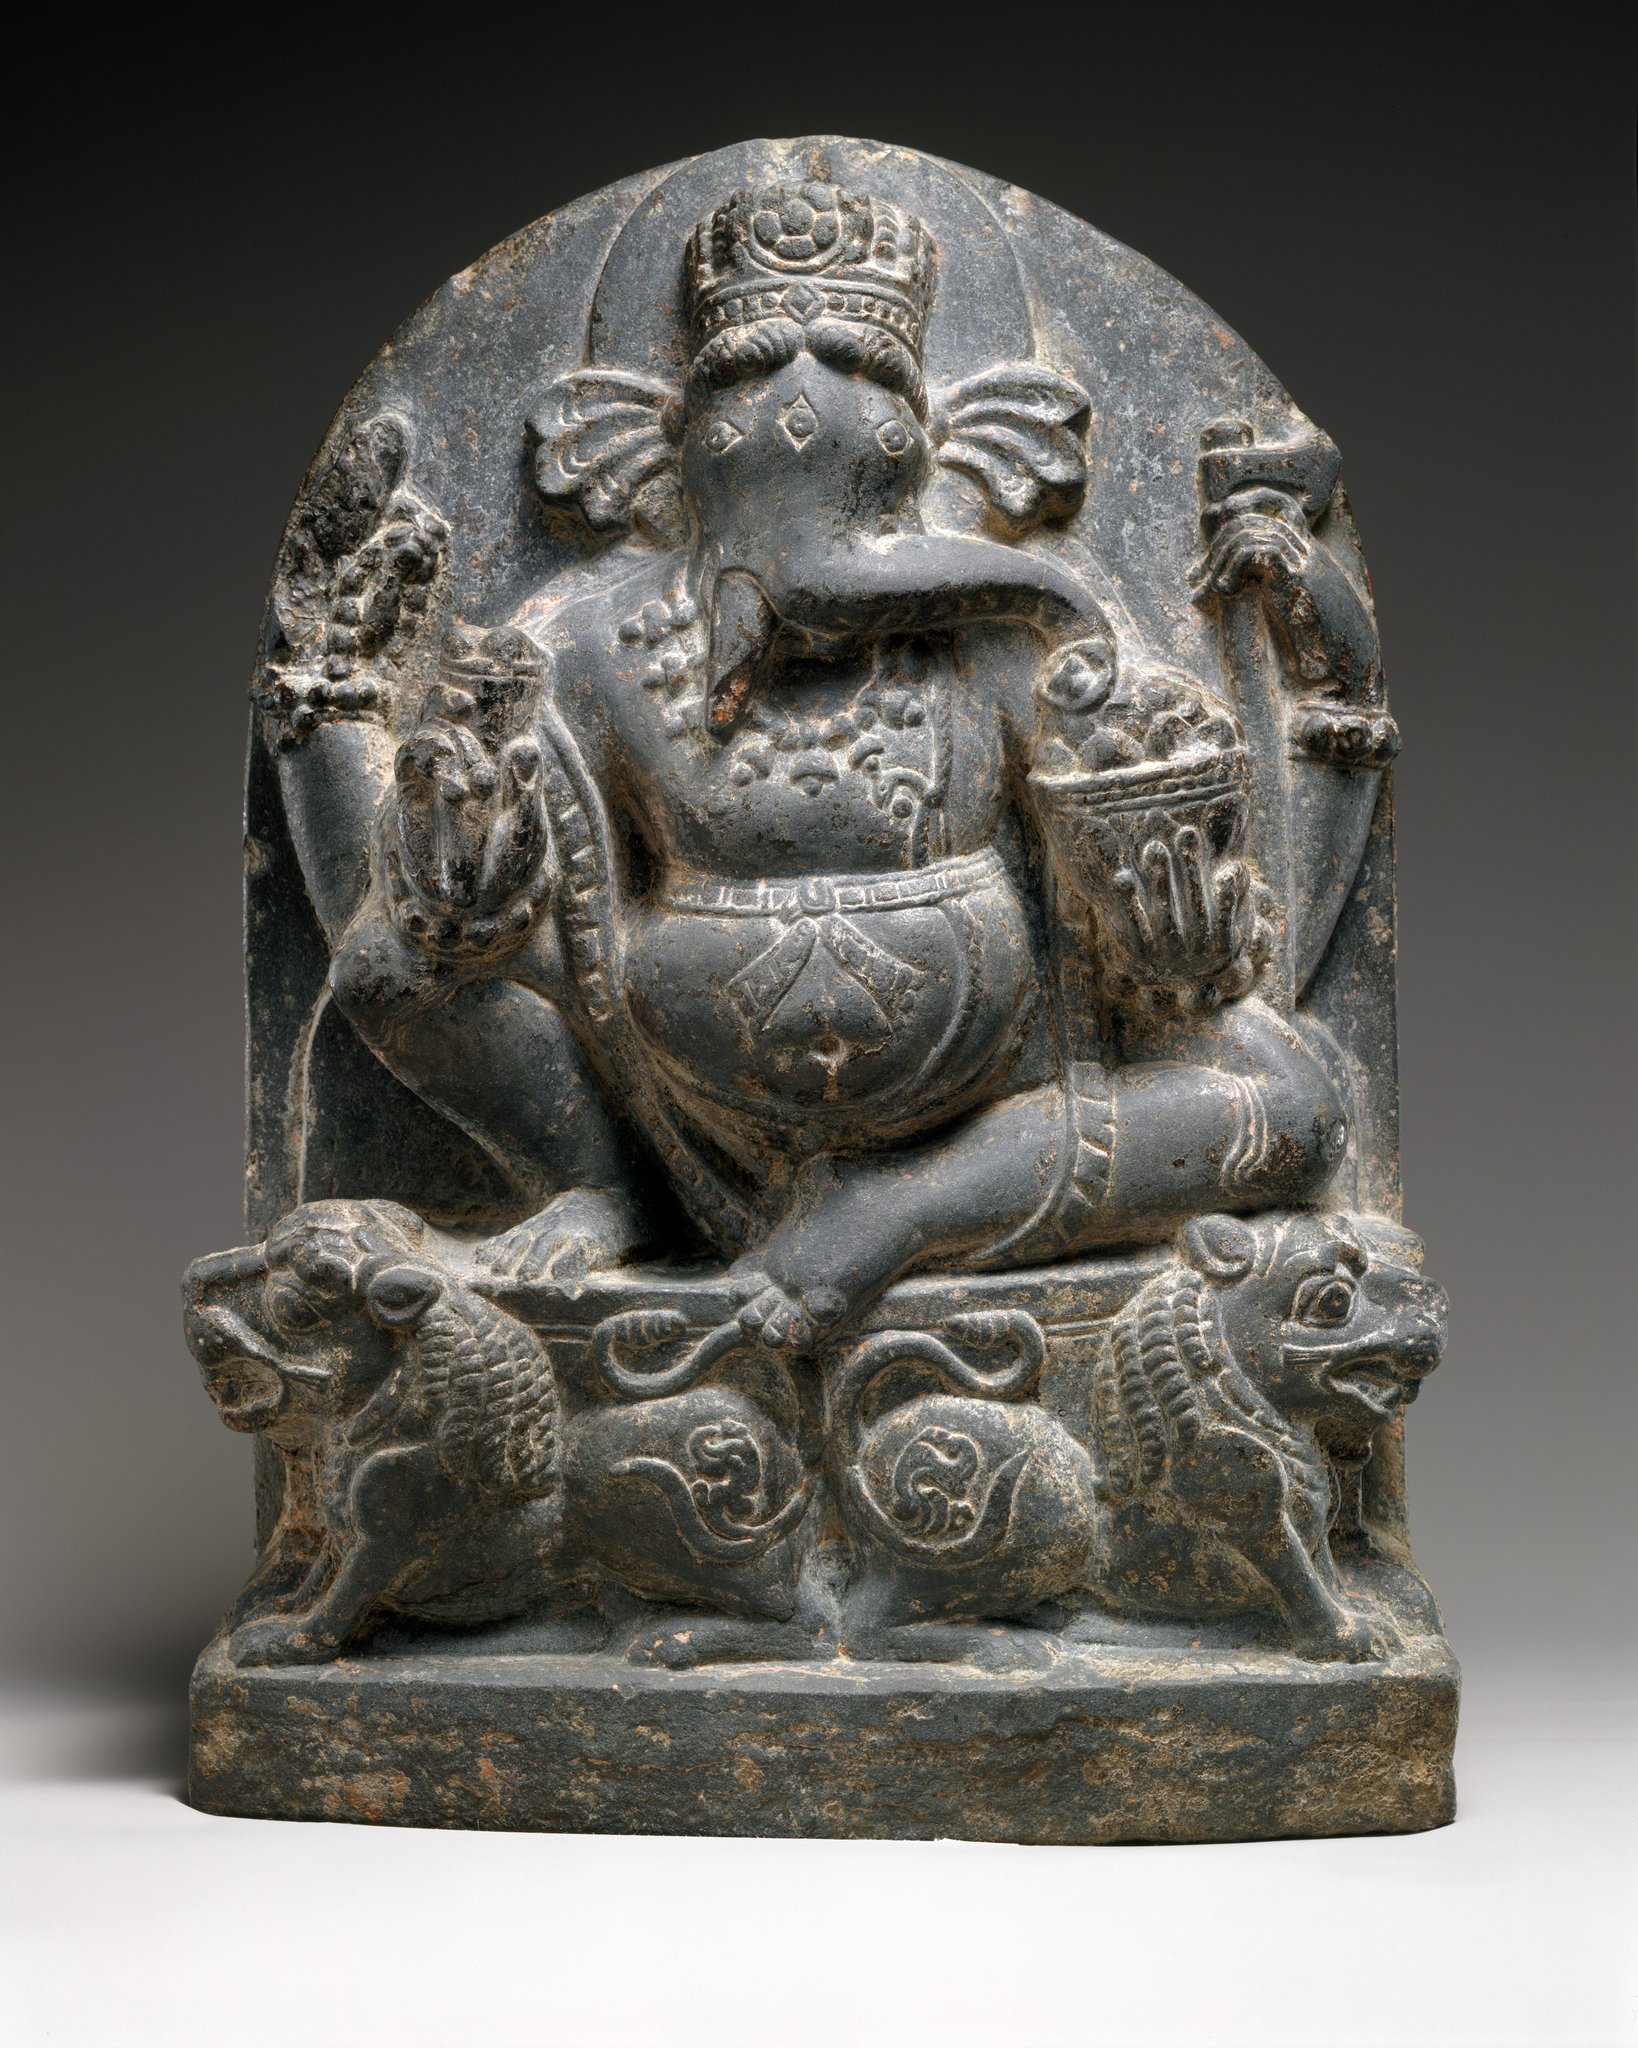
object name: figure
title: Ganesha Seated on a Lion Throne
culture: indian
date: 901-1000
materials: stone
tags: lions,ganesha,hinduism